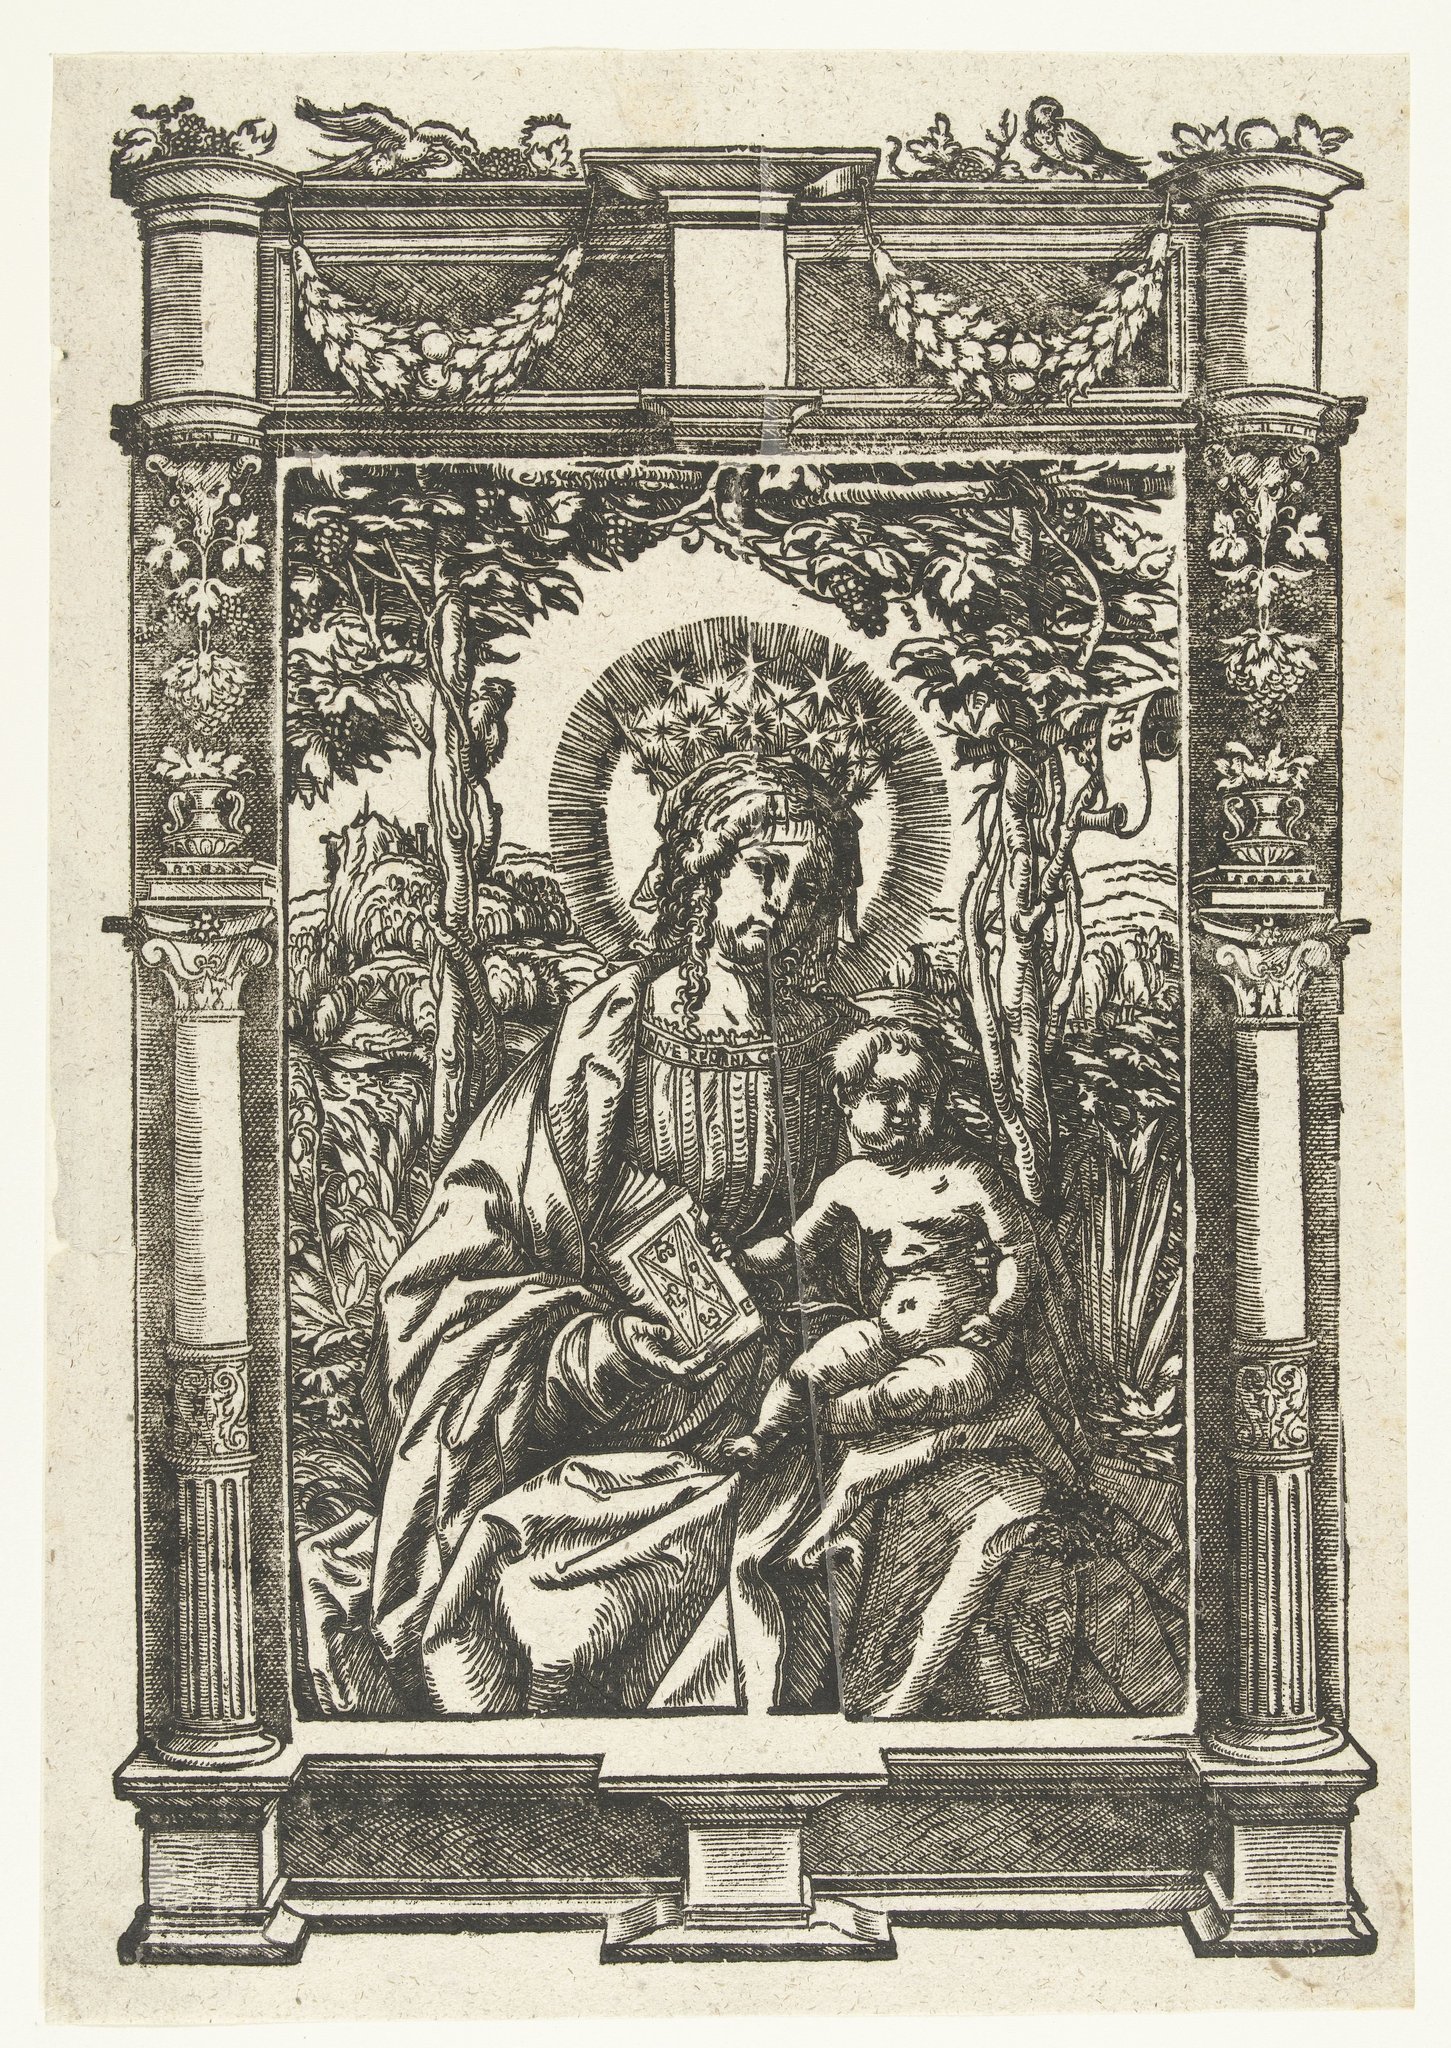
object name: print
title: Maria met kind in architecturale omlijsting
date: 1483-1531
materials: paper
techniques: woodcut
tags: madonna: mary sitting or enthroned, the christ-child in her lap (or in front of her bosom) (mary sometimes represented half-length)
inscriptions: collector's mark: Lugt 240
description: Zittende Maria met het Christuskind op haar schoot en een boek in haar hand. Op haar hoofd draagt zij een kroon met sterren. Op de achtergrond is een landschap met een prieel met wijnranken weergegeven. De voorstelling is geplaatst in een rechthoekige omlijsting met architectuur ornamenten zoals zuilen en lijsten. De prent is gedrukt met twee houtblokken.